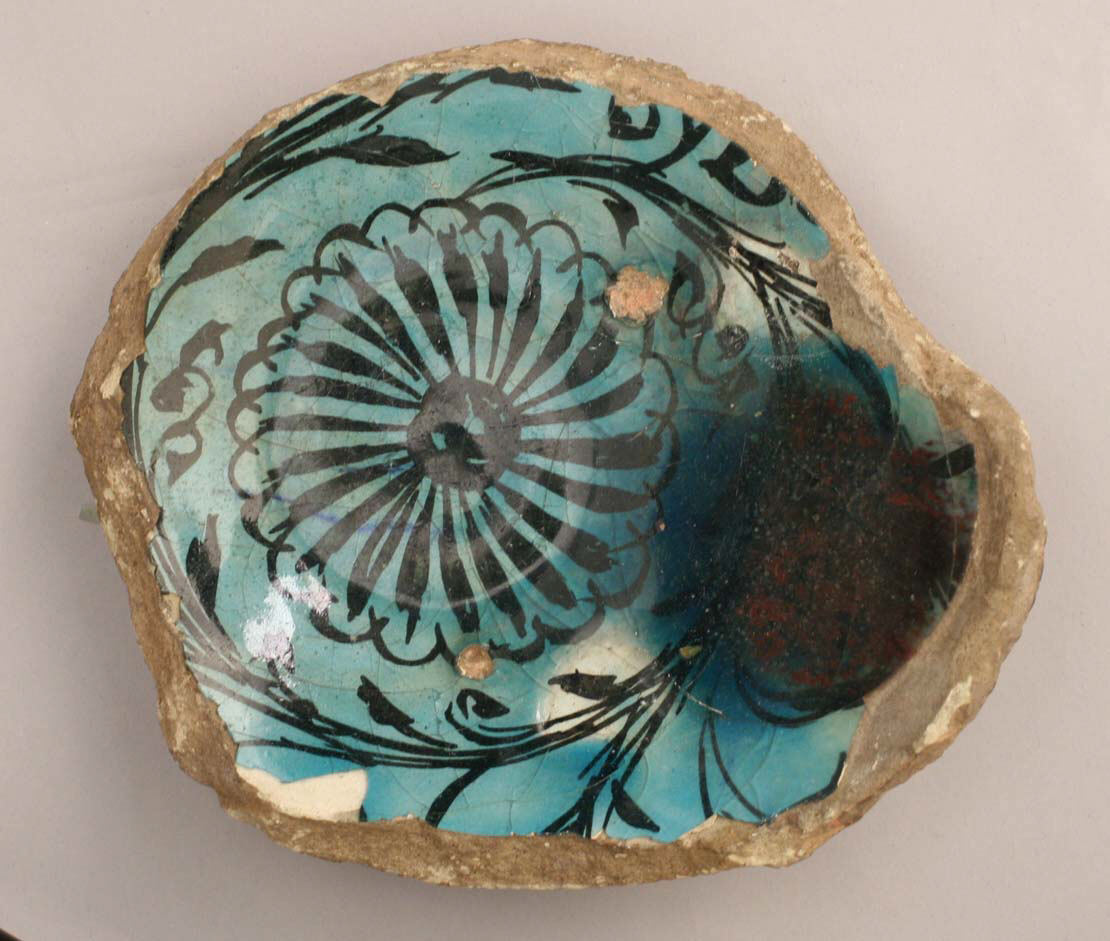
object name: ceramic fragment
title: Fragment of Bowl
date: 1401-1500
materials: glaze, stonepaste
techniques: painting, underglaze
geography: syria